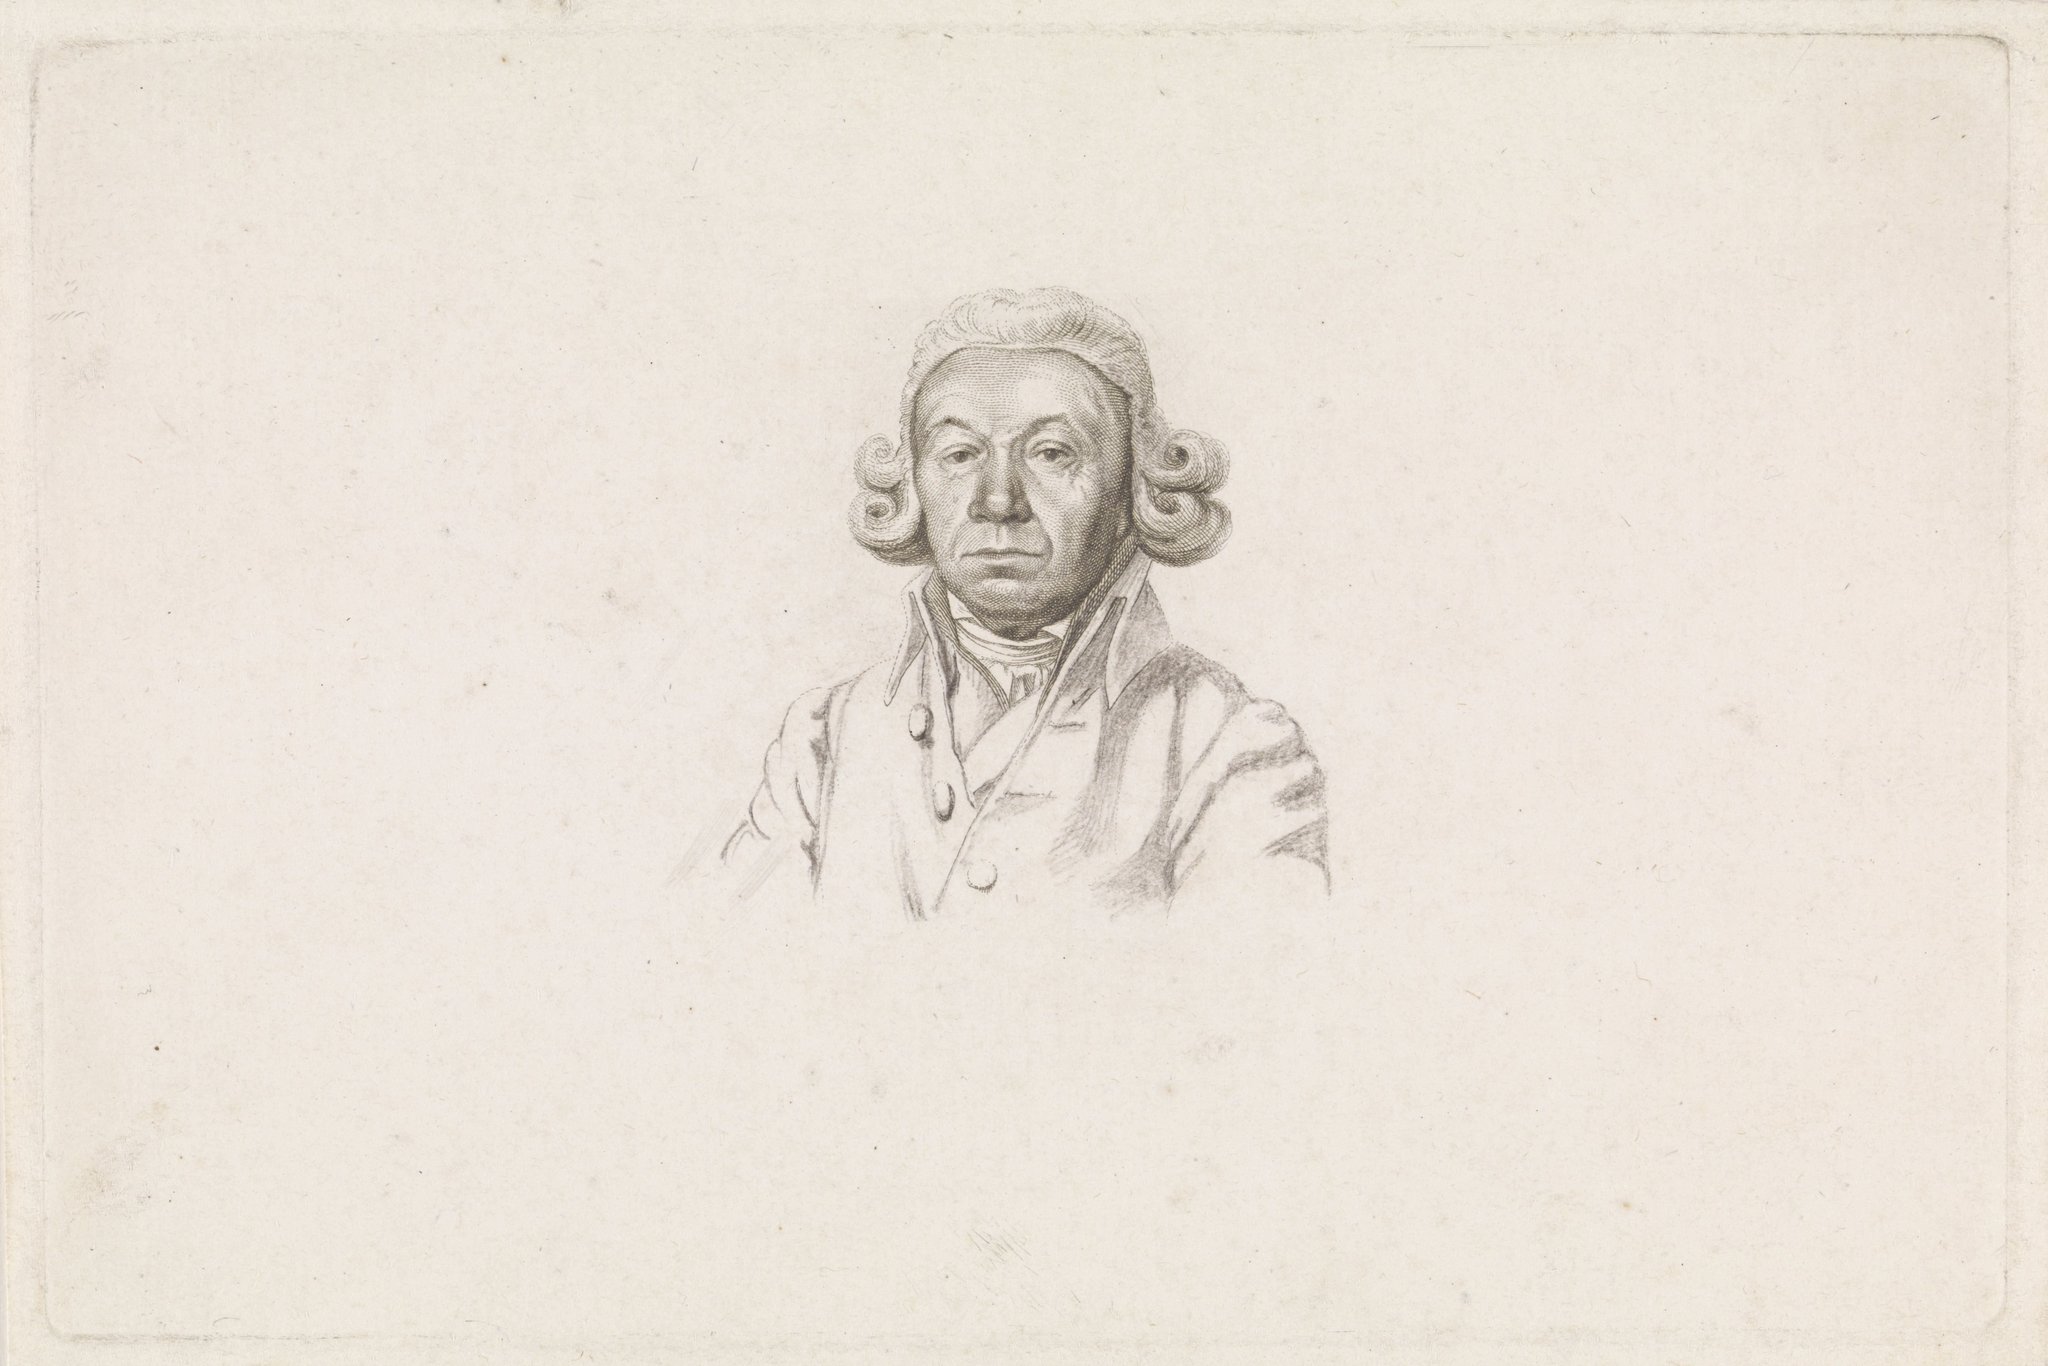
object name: print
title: Portret van Izaak Schmidt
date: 1812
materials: chalk, paper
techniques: etching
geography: amsterdam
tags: izaak schmidt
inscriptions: collector's mark: Lugt 2228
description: Latere staat van de prent gebruikt in: Jacob Ernst Marcus, Etudes gravées. Amsterdam: S. de Grebber, 1826.